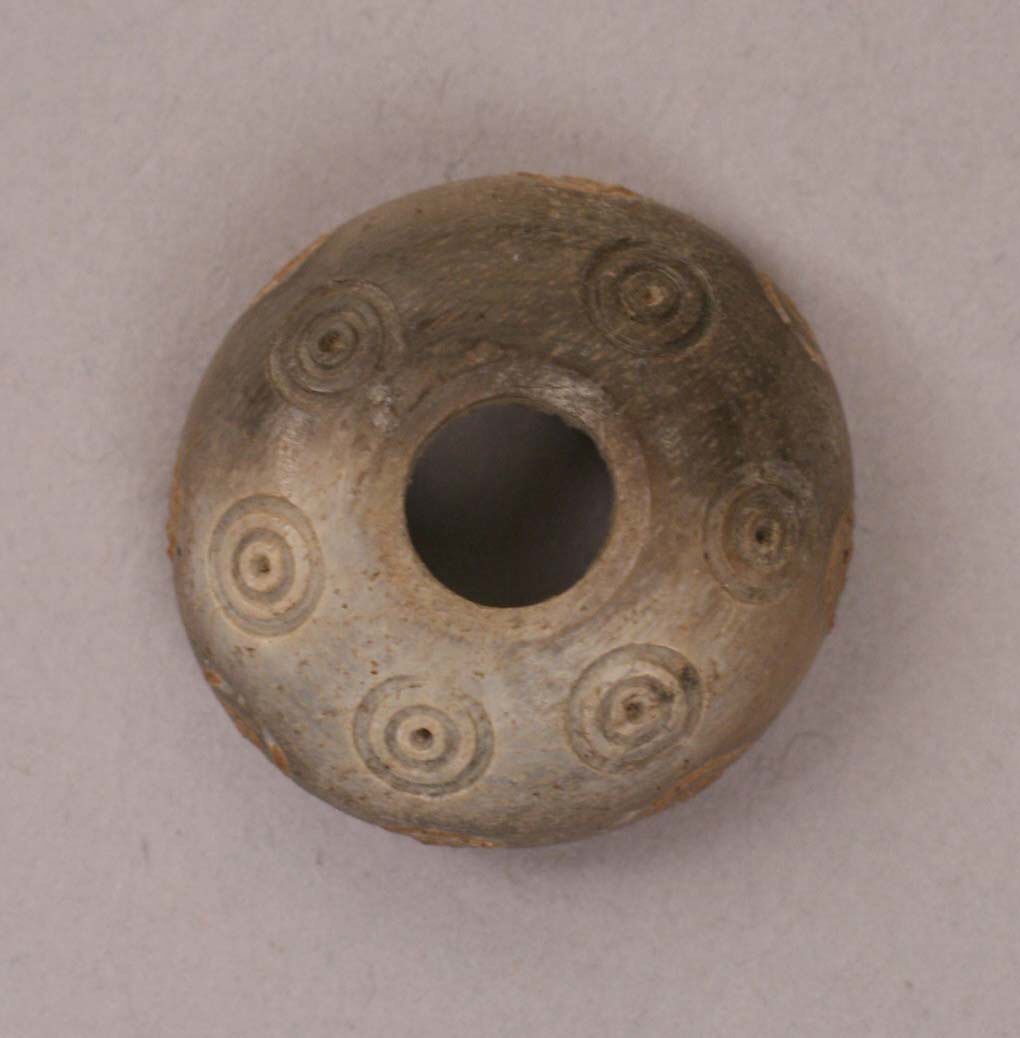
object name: button or bead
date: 801-1000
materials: bone, paint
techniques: incising, inlay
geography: iran